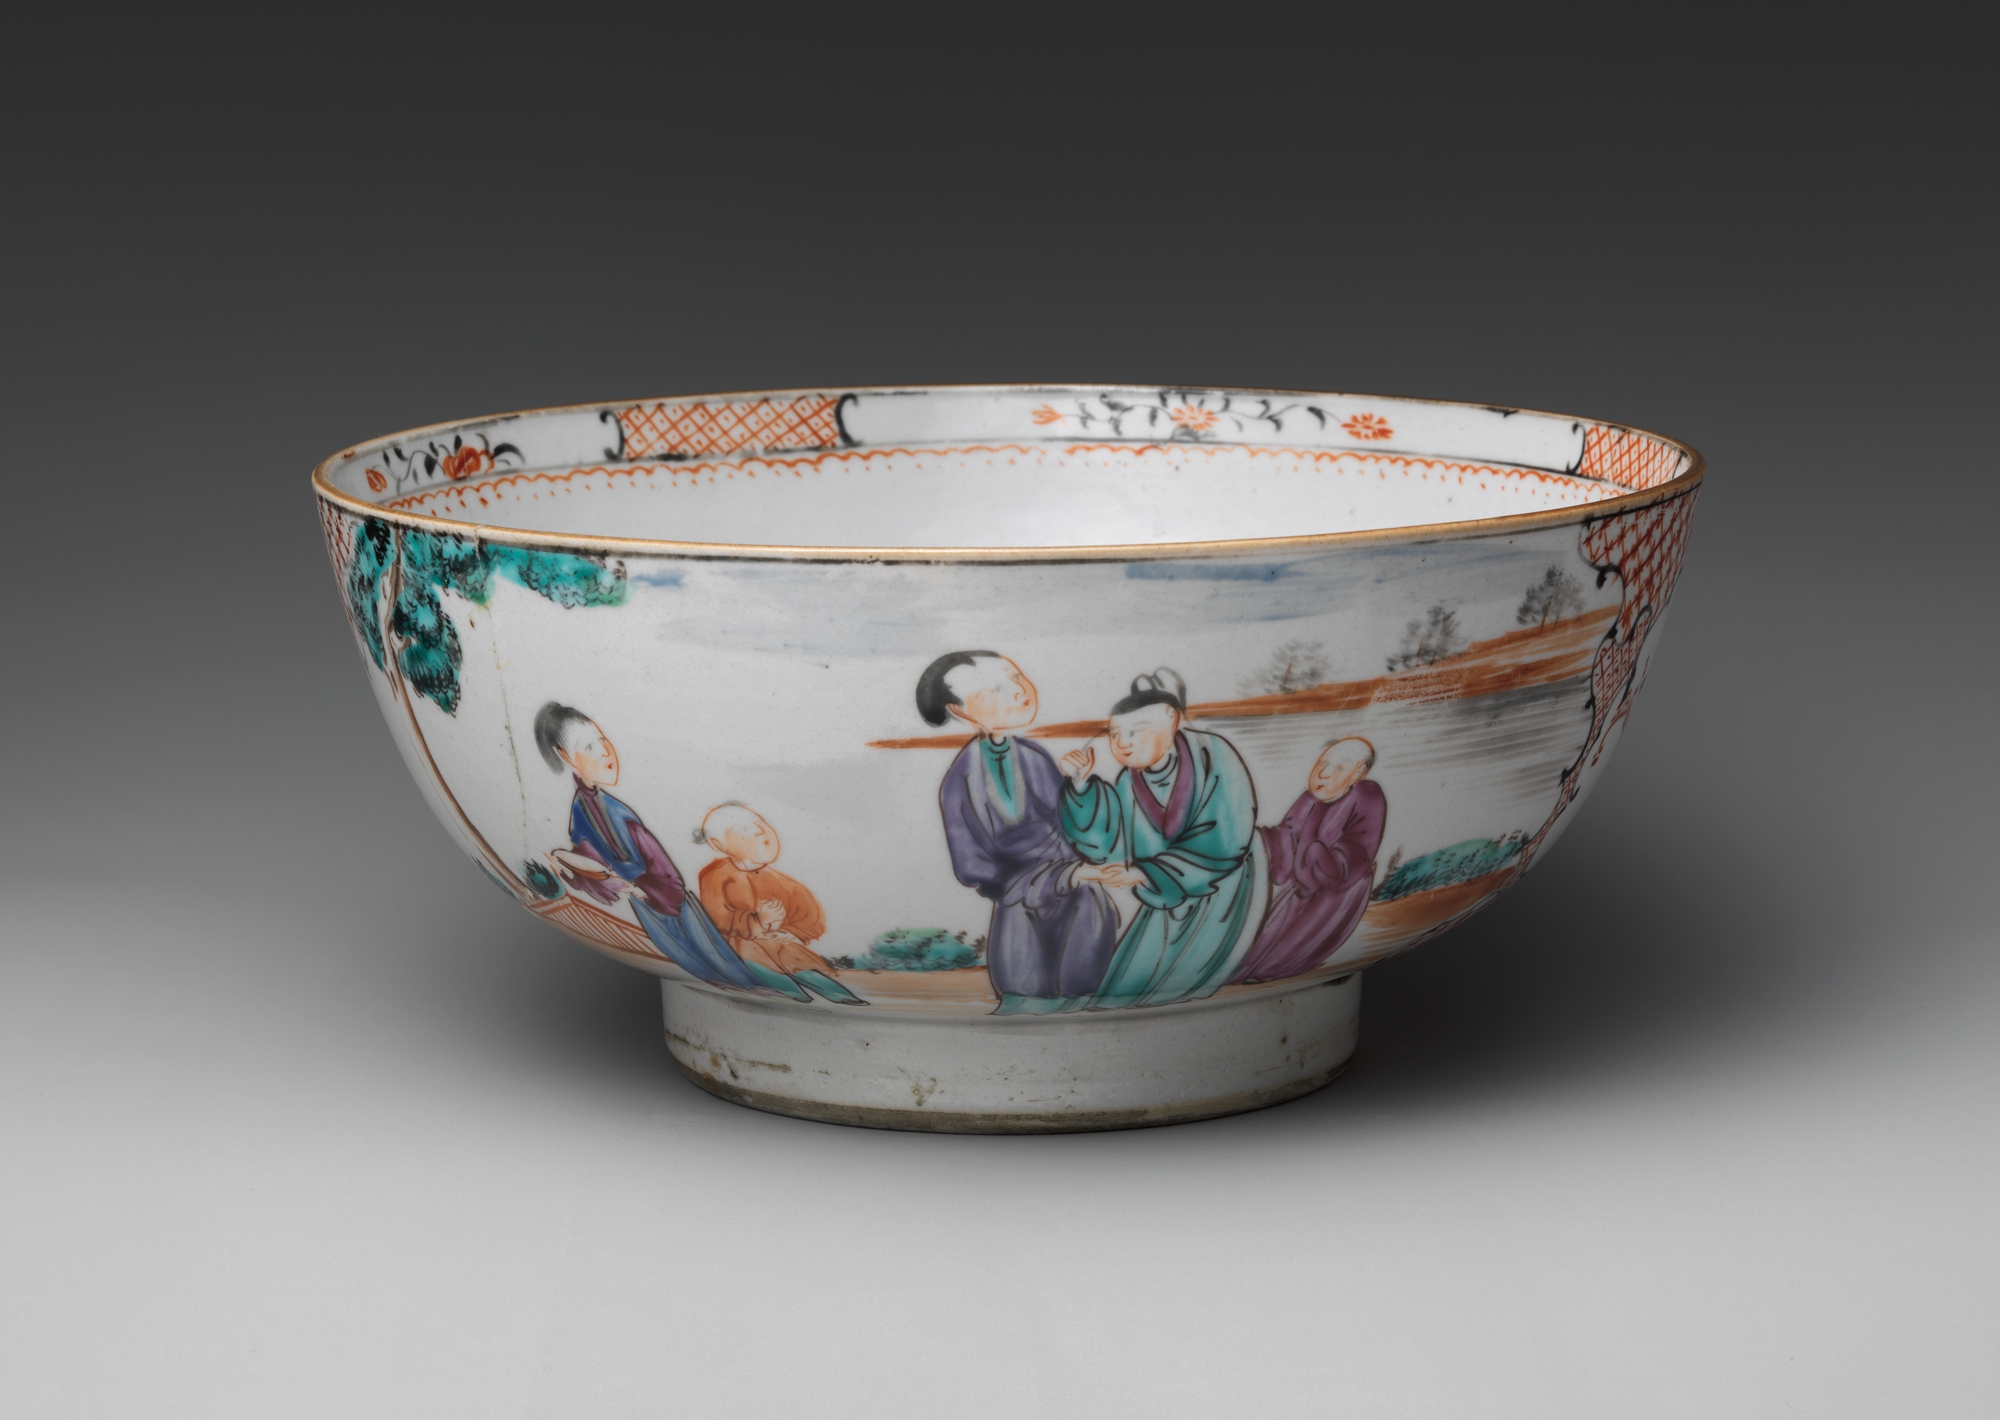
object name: bowl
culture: chinese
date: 1736-1795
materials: porcelain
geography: china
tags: boys,men,women